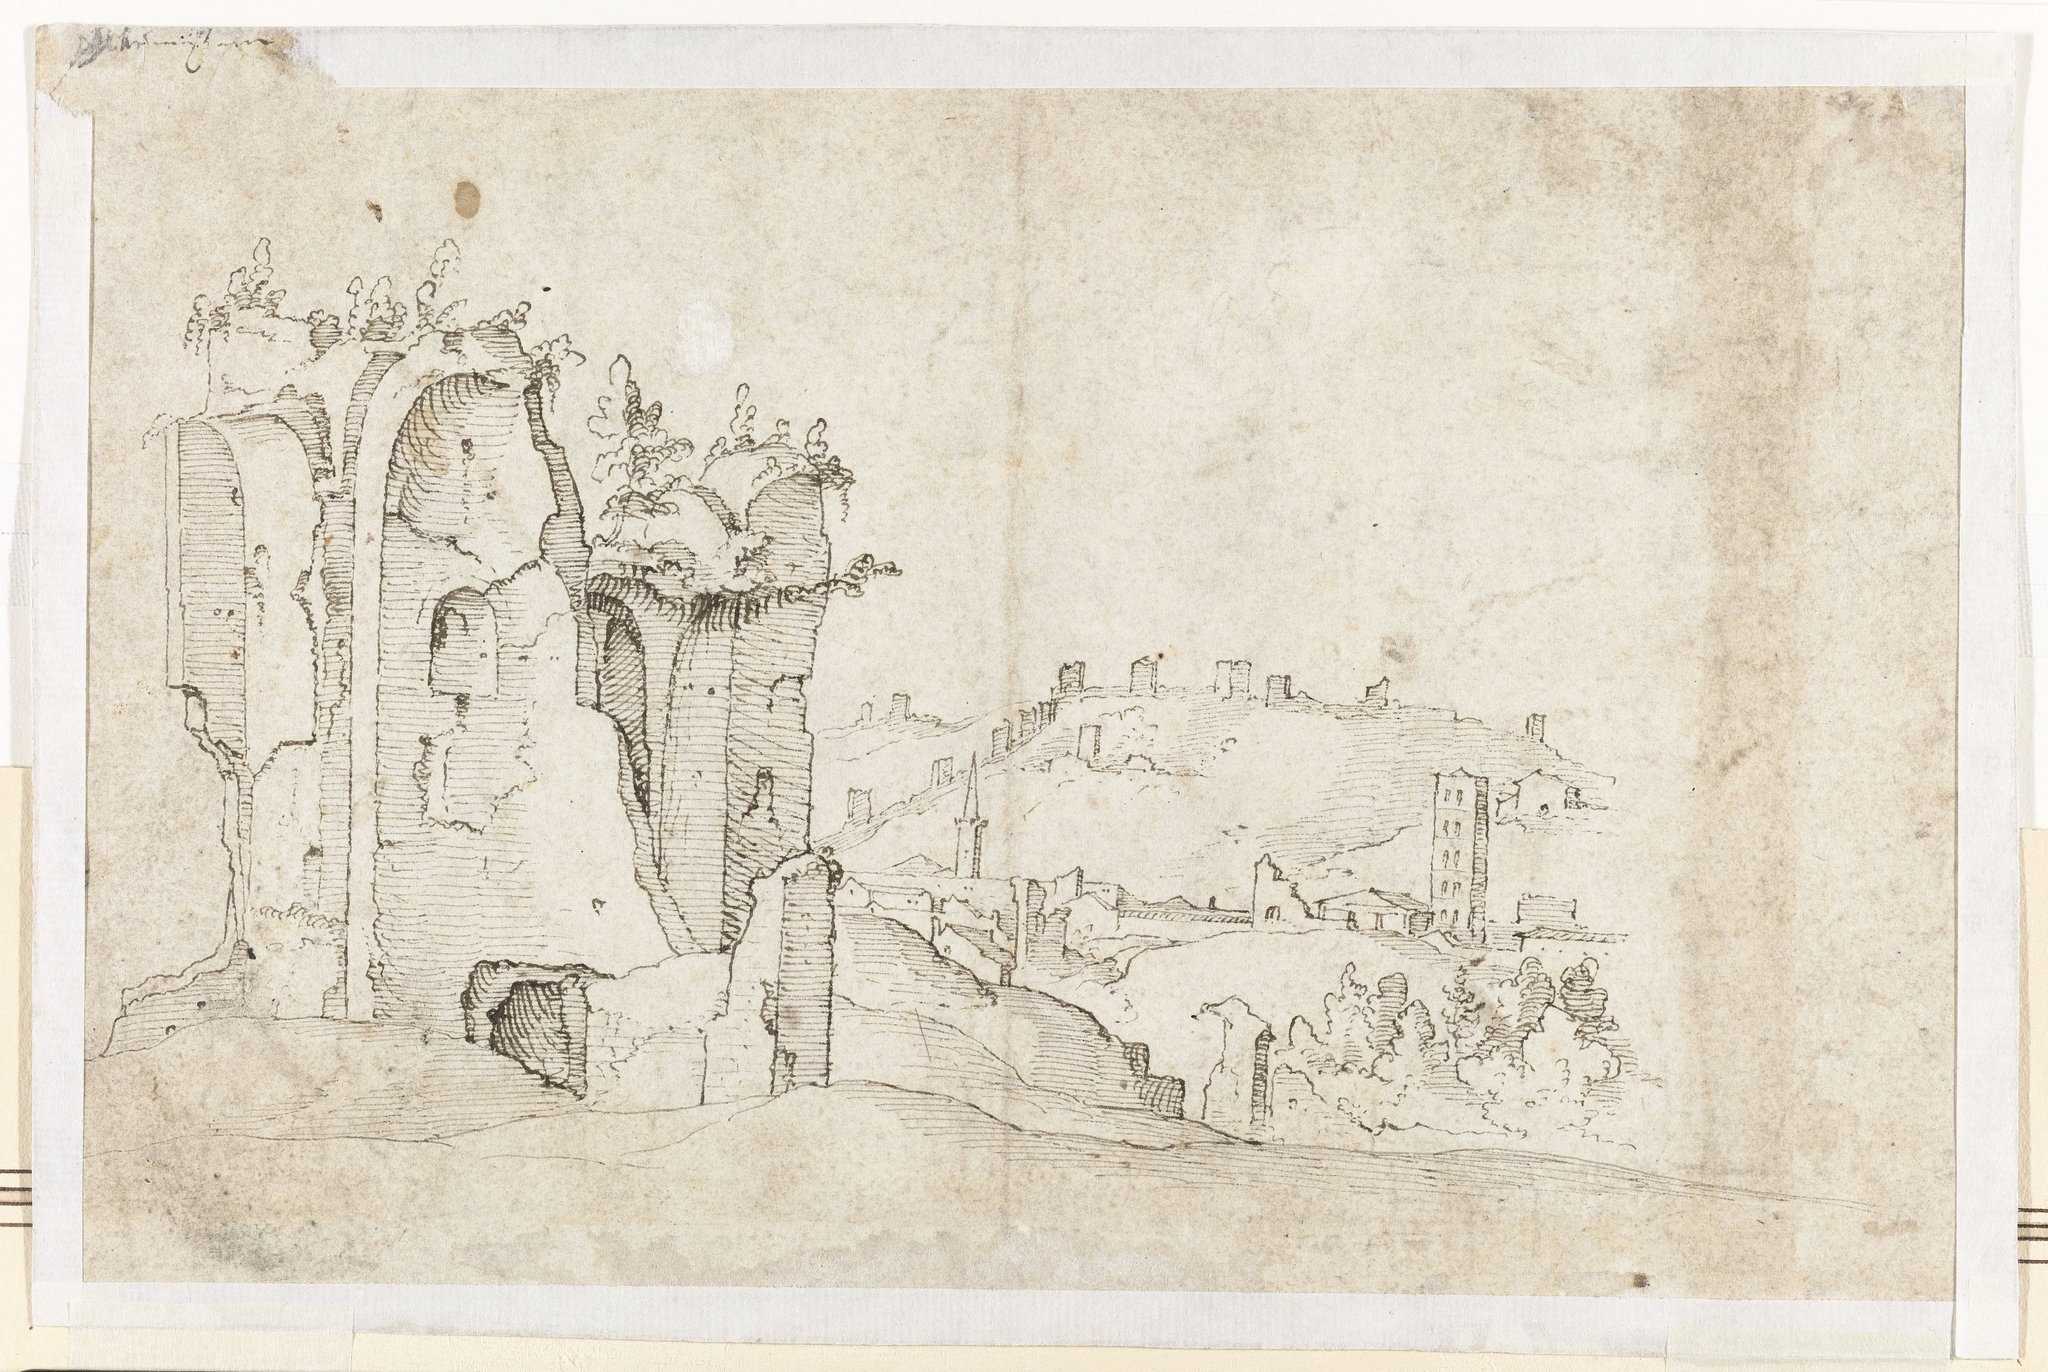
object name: drawing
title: Een ongeïdentificeerde ruïne in Rome; op de achtergrond een deel van de Romeinse stadsmuur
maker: martinus van heemskerck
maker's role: draughtsman, painter, print maker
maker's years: 1498-1574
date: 1532-1537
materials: ink, paper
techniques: pen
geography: rome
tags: ruin of a building ~ architecture, landscape with ruins